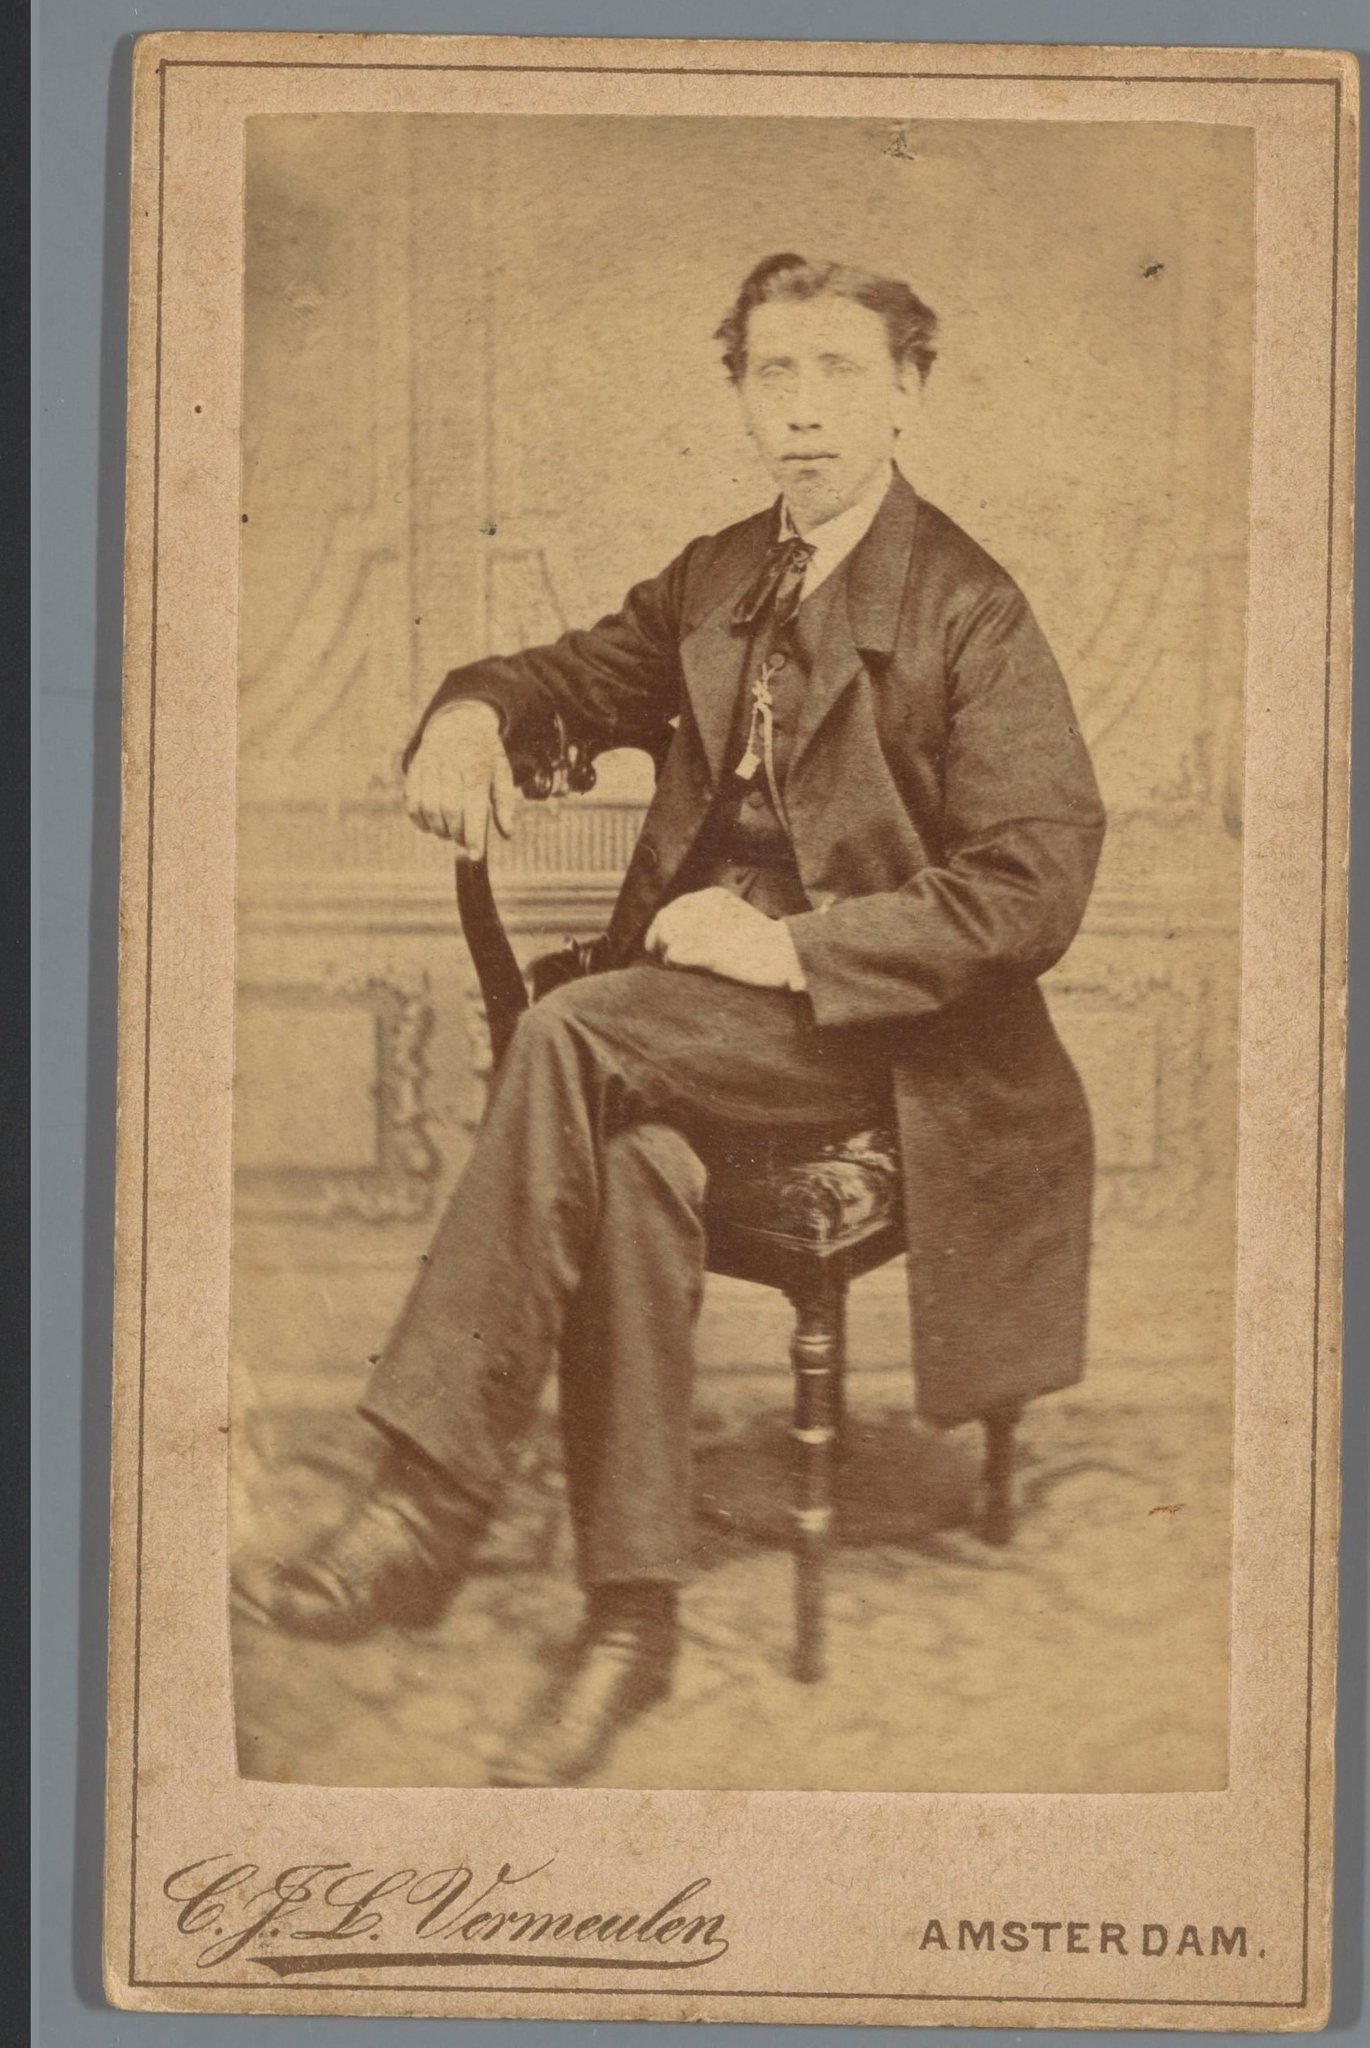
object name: photograph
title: Portret van een onbekende man, aangeduid als oom Dorius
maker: cornelis johannes lodewicus vermeulen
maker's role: fotograaf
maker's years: 1861-1936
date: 1888-1896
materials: cardboard, paper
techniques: albumen print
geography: amsterdam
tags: adult man, historical persons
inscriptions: inscription: ‘oom Dorius’, inscription: ‘Photographische/ ATELIERS/ C. J. L. Vermeulen/ Heerenstraat 6,/ Heiligenweg/ hoek Singel/ AMSTERDAM,/ Specialiteit in vergrootingen.’